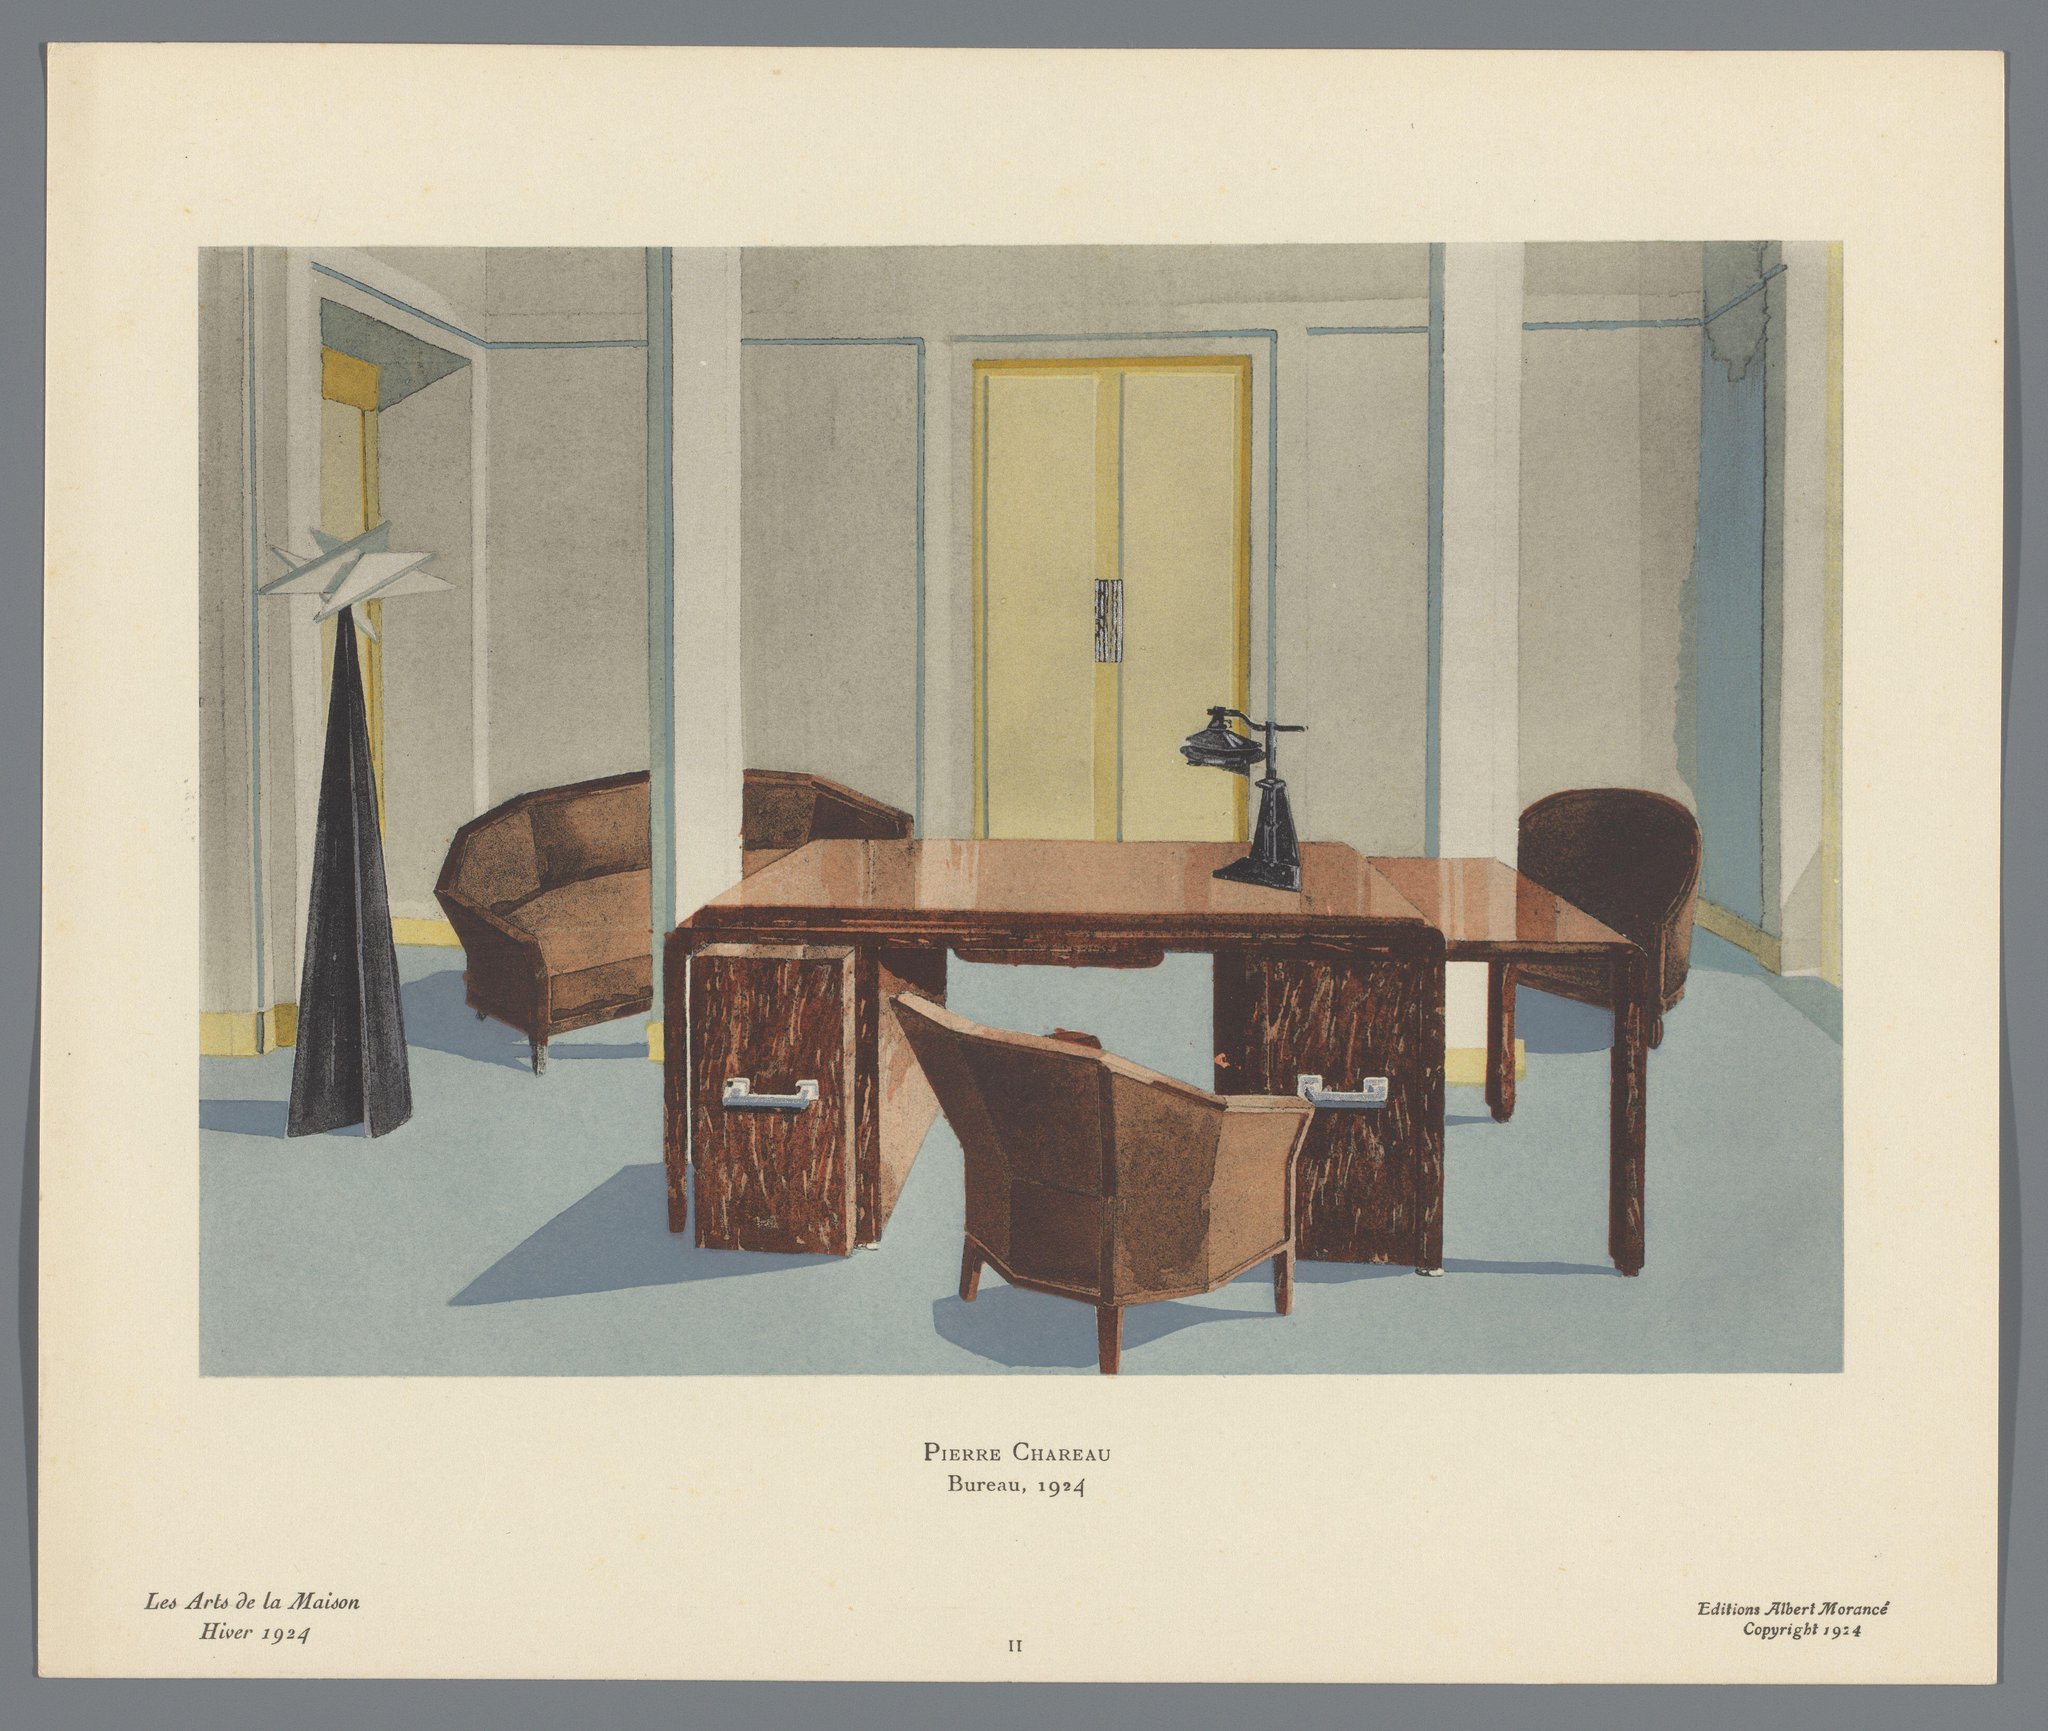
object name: photograph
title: Pierre Chareau. Bureau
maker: Anonymous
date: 1924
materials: paper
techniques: photograph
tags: france